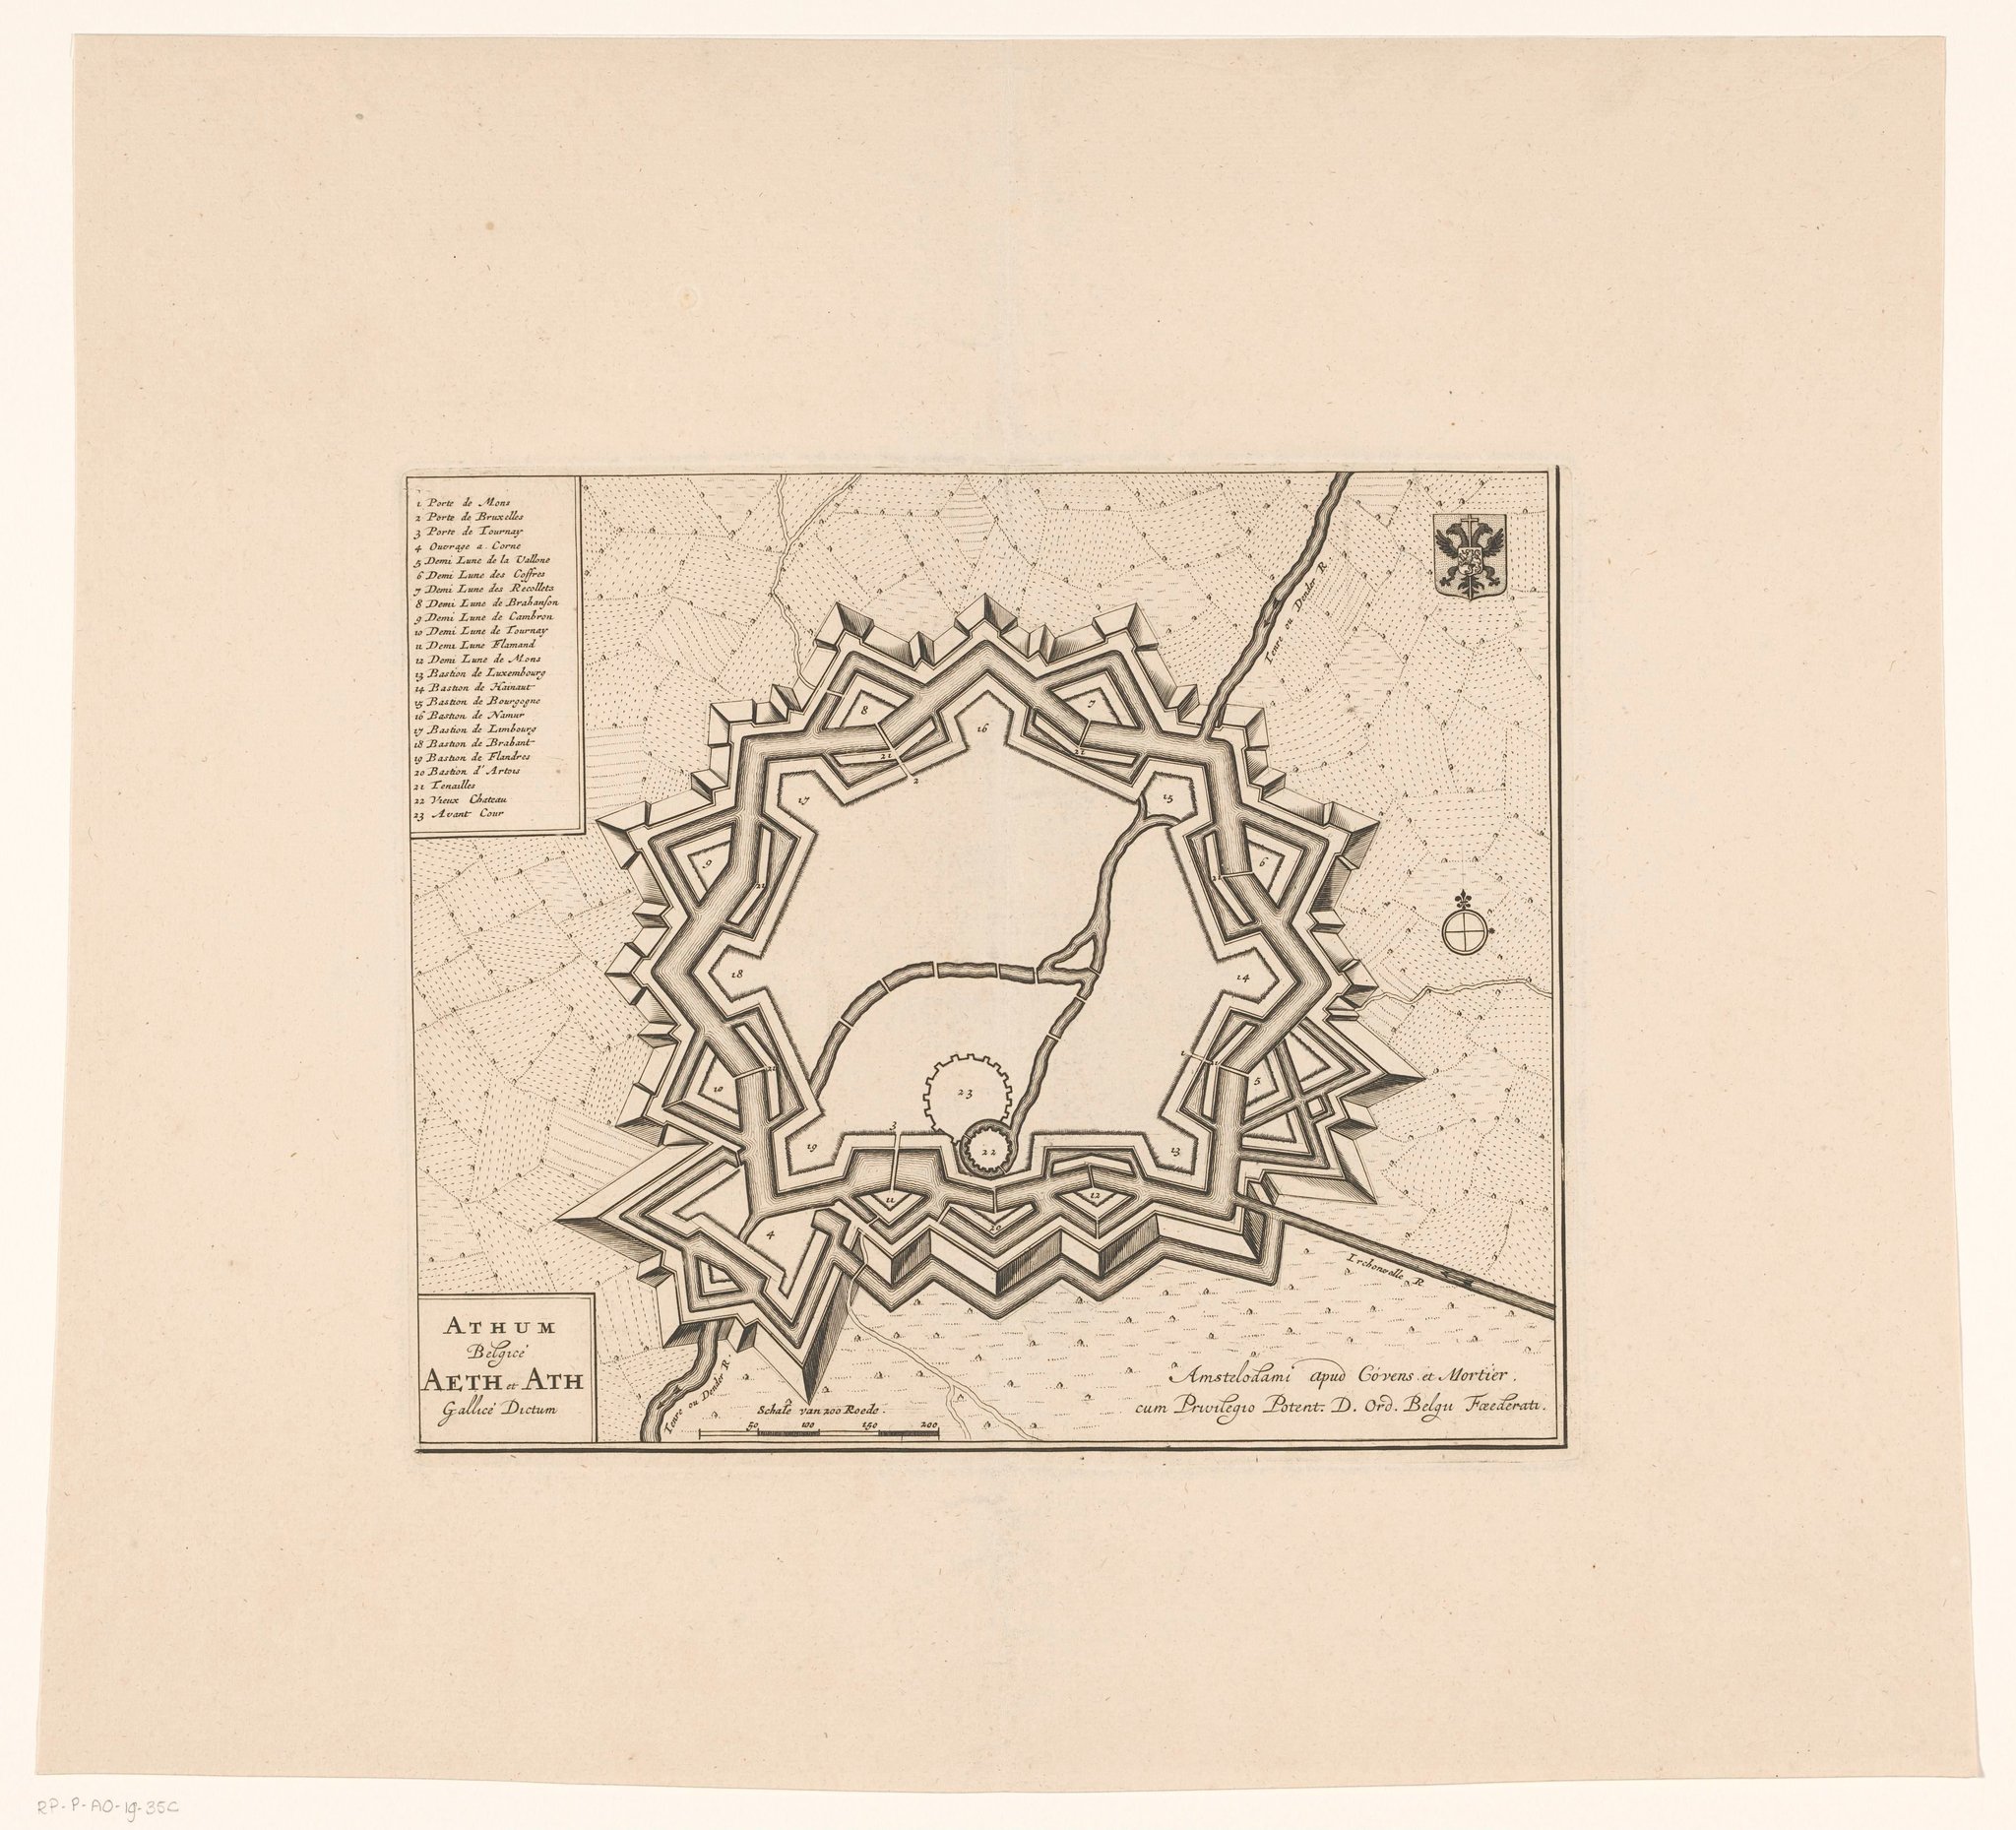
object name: print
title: Athum Belgicé Aeth et Ath Gallicé dictum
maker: Anonymous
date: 1728-1774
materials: paper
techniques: engraving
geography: amsterdam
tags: coat of arms (as symbol of the state, etc.) (+ city; municipal), fortified city, maps of cities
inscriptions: collector's mark: Lugt 2228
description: Vestingplattegrond van Aat. Linksonder een kader met de titel. Rechts daarvan een schaalstok: Schale van 200 Roede. Linksboven een kader met legenda 1-23. Rechtsboven het wapen van Aat.